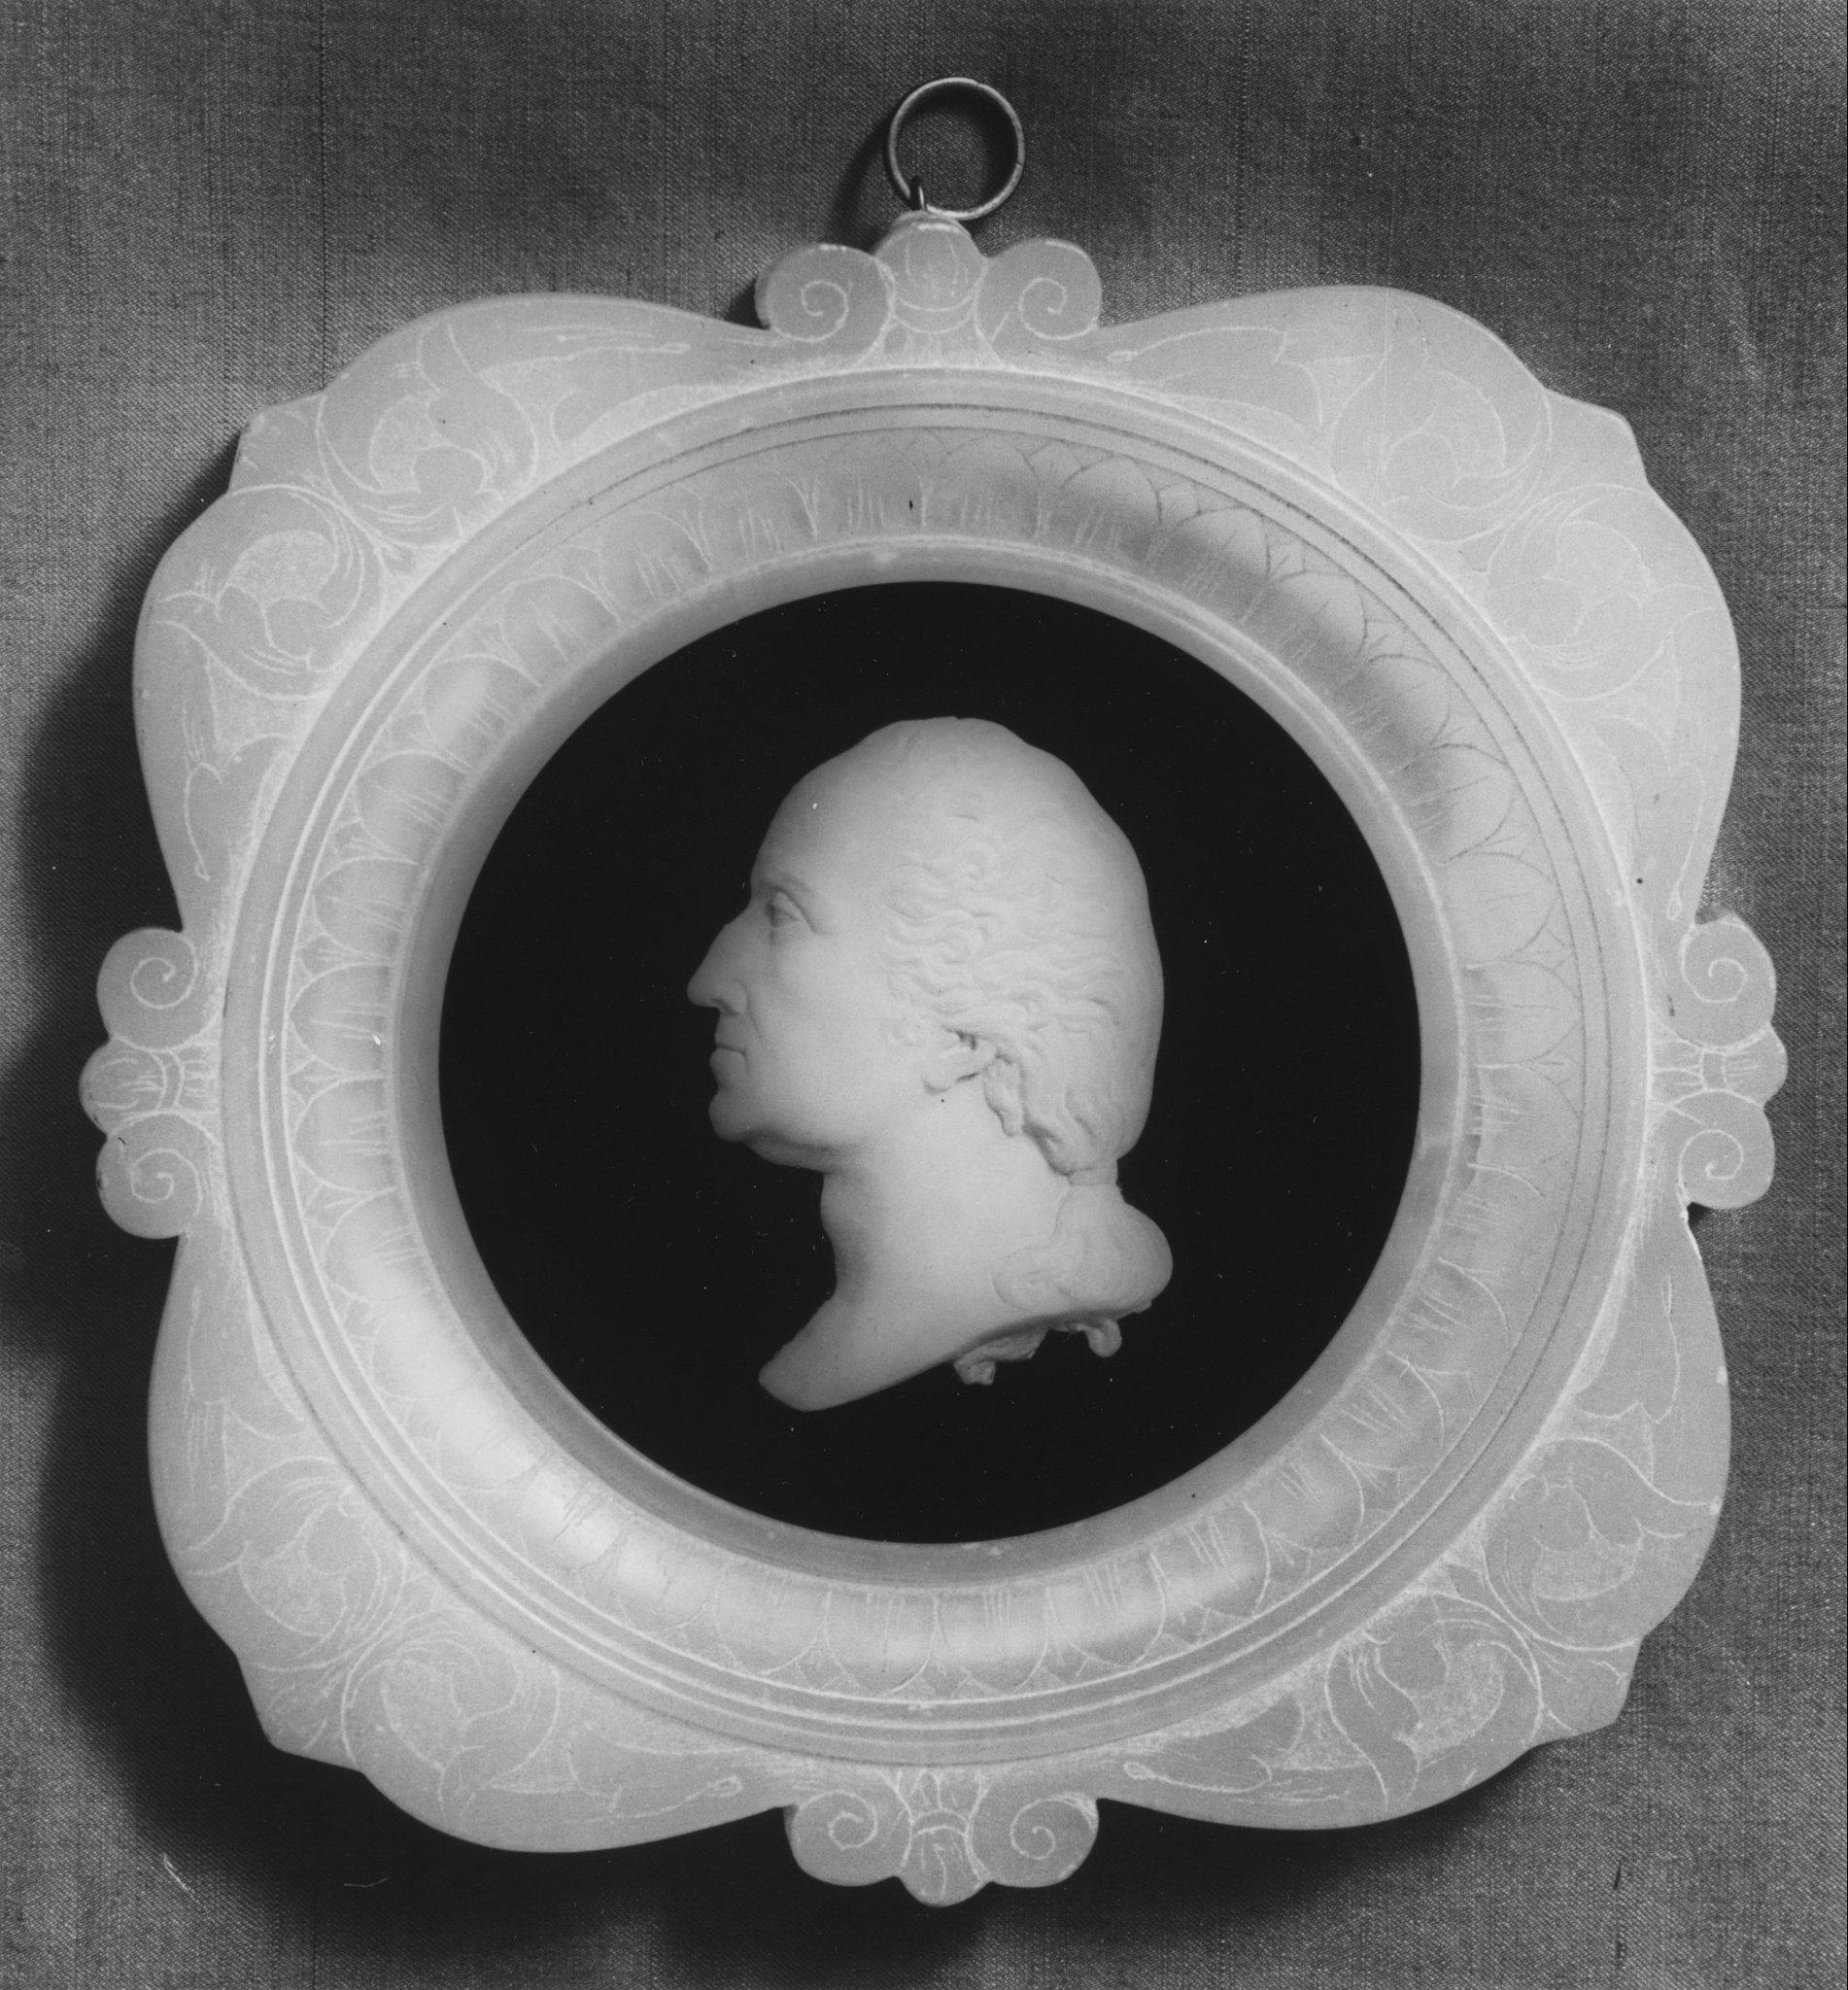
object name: plaque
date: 1870-1900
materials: glass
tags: men,profiles